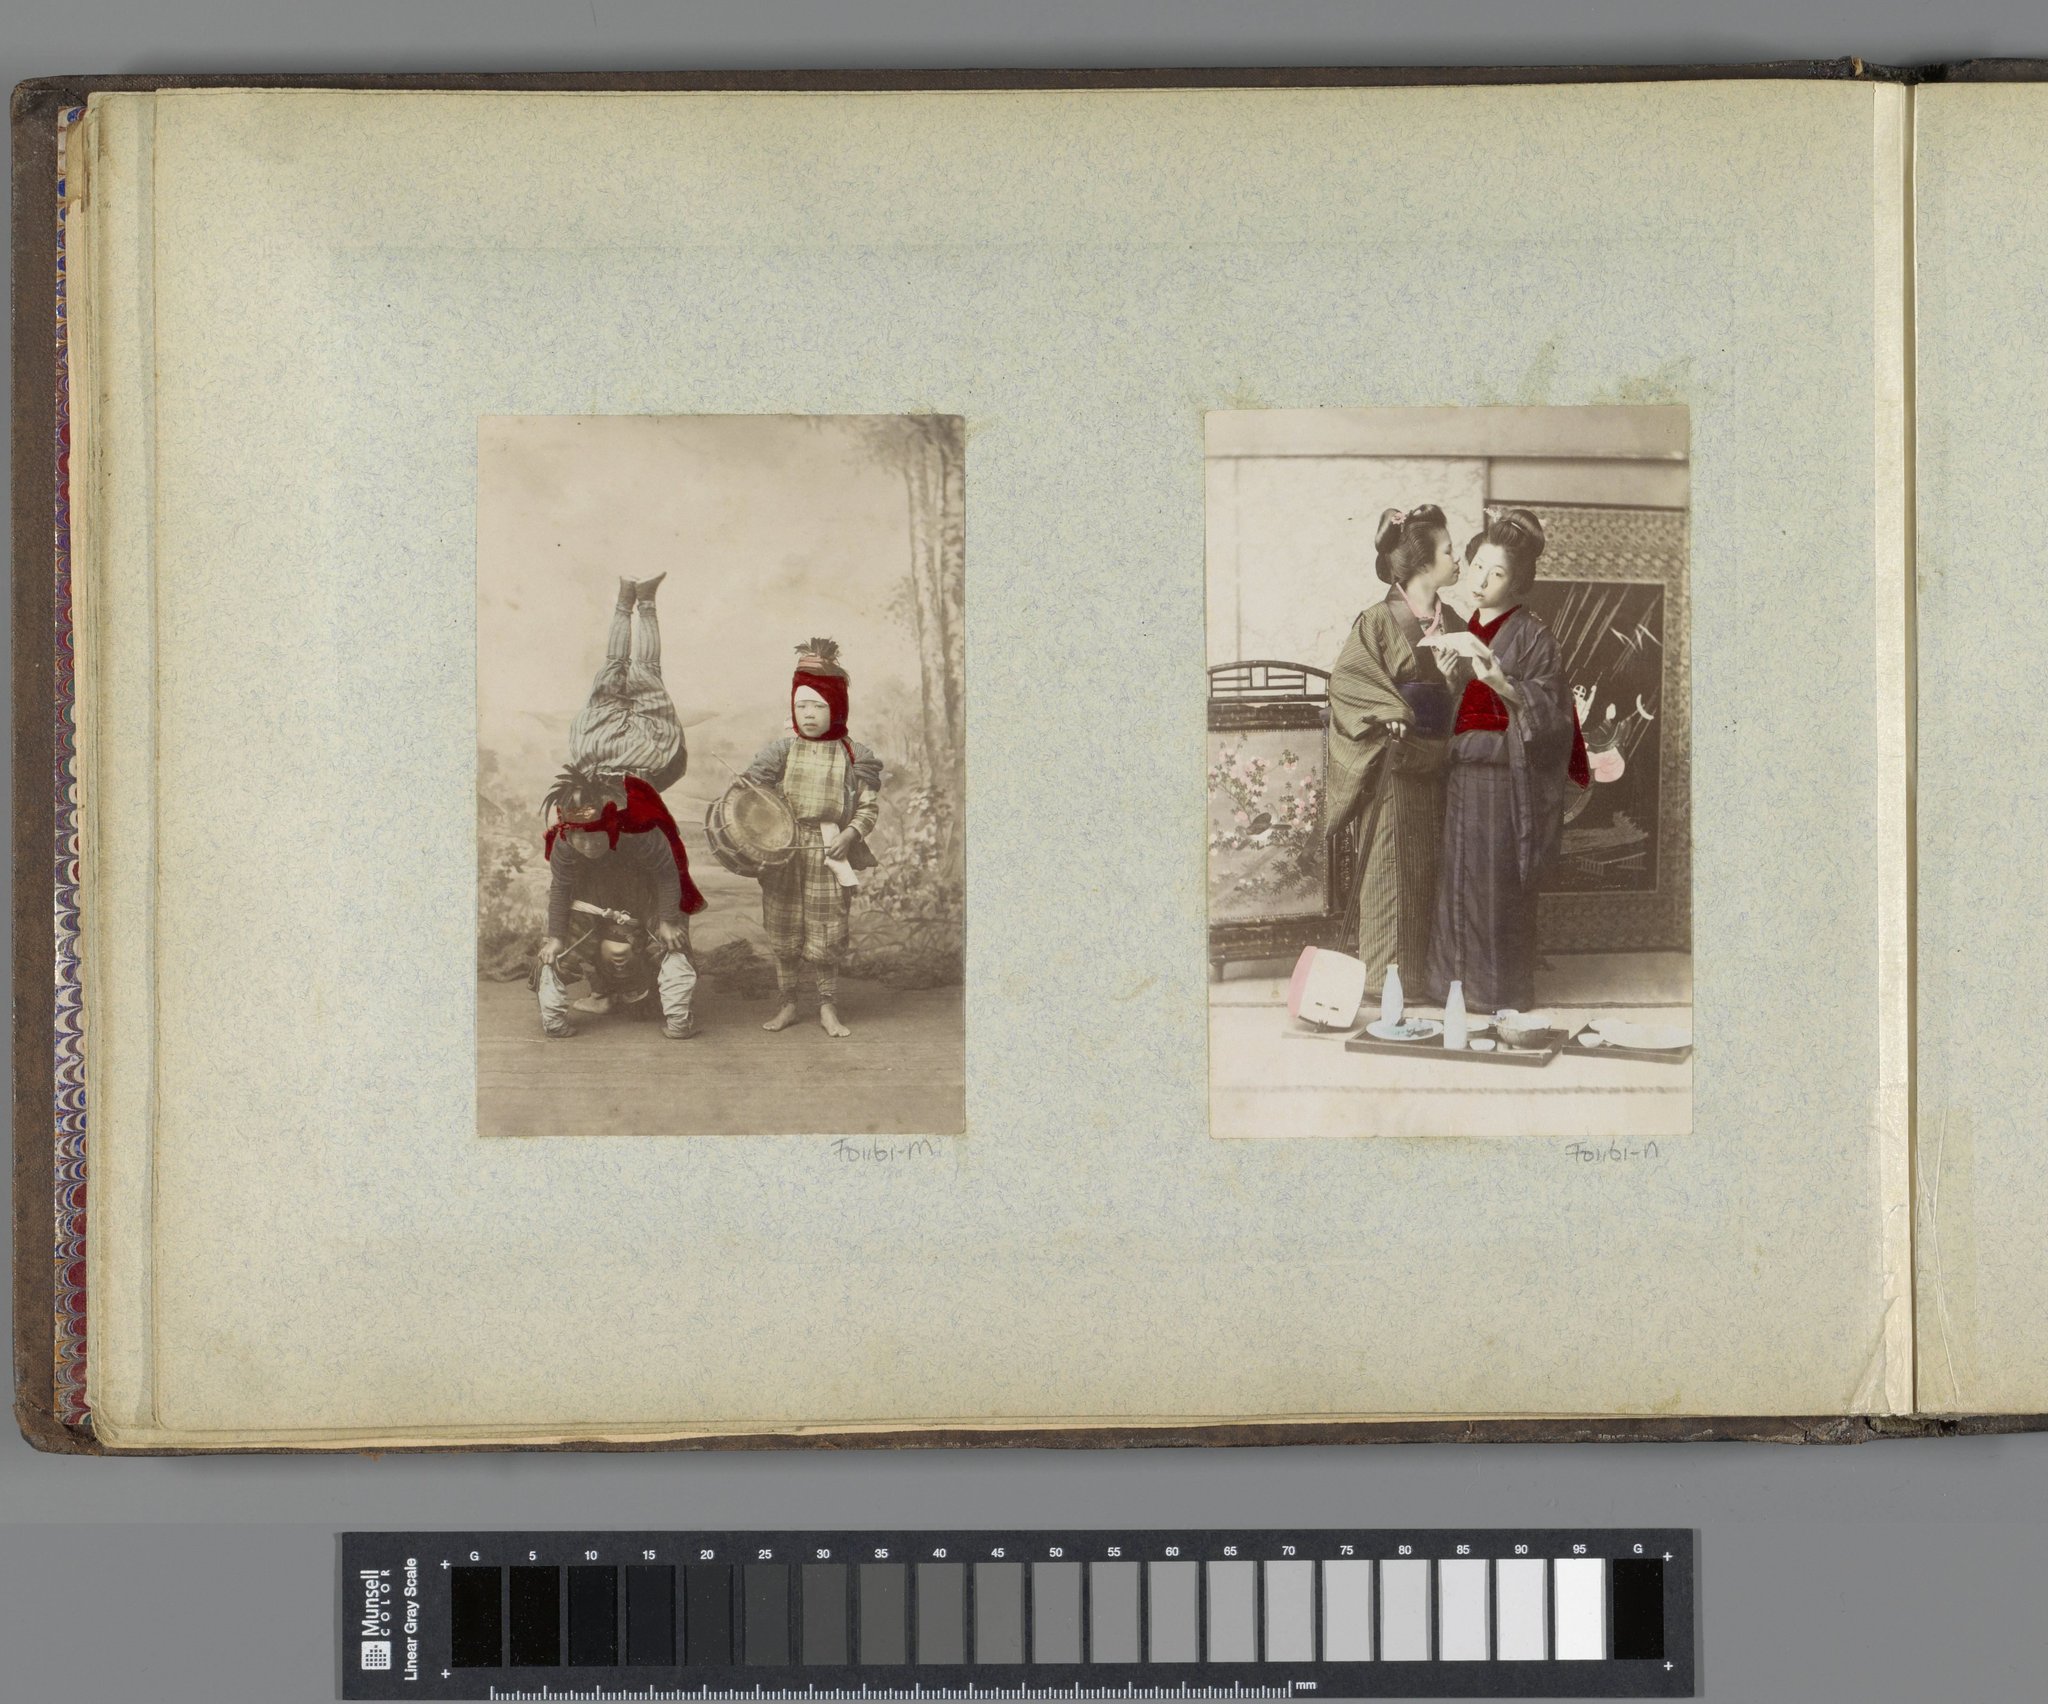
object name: photograph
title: Portret van drie Japanse kinderen: één trommelaar, twee acrobaten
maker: Anonymous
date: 1870-1891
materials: paper, photographic support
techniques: albumen print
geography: japan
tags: acrobat ~ circus, drum (musical instrument), japan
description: Onderdeel van Fotoalbum van een reis naar Manilla.